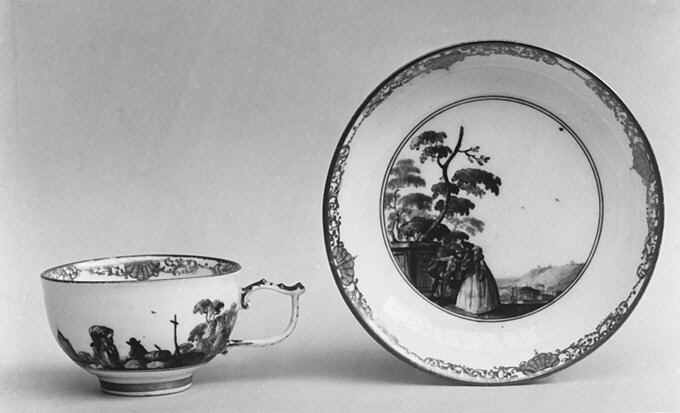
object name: cup and saucer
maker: meissen manufactory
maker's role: manufactory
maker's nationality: german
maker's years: 1710-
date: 1740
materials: hard paste porcelain